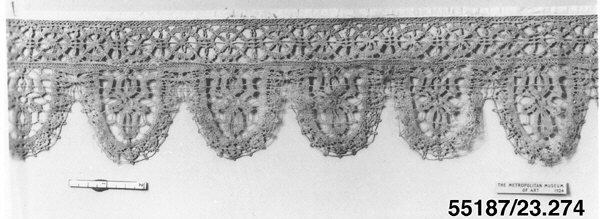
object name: strip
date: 1601-1700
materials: silk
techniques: lace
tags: flowers